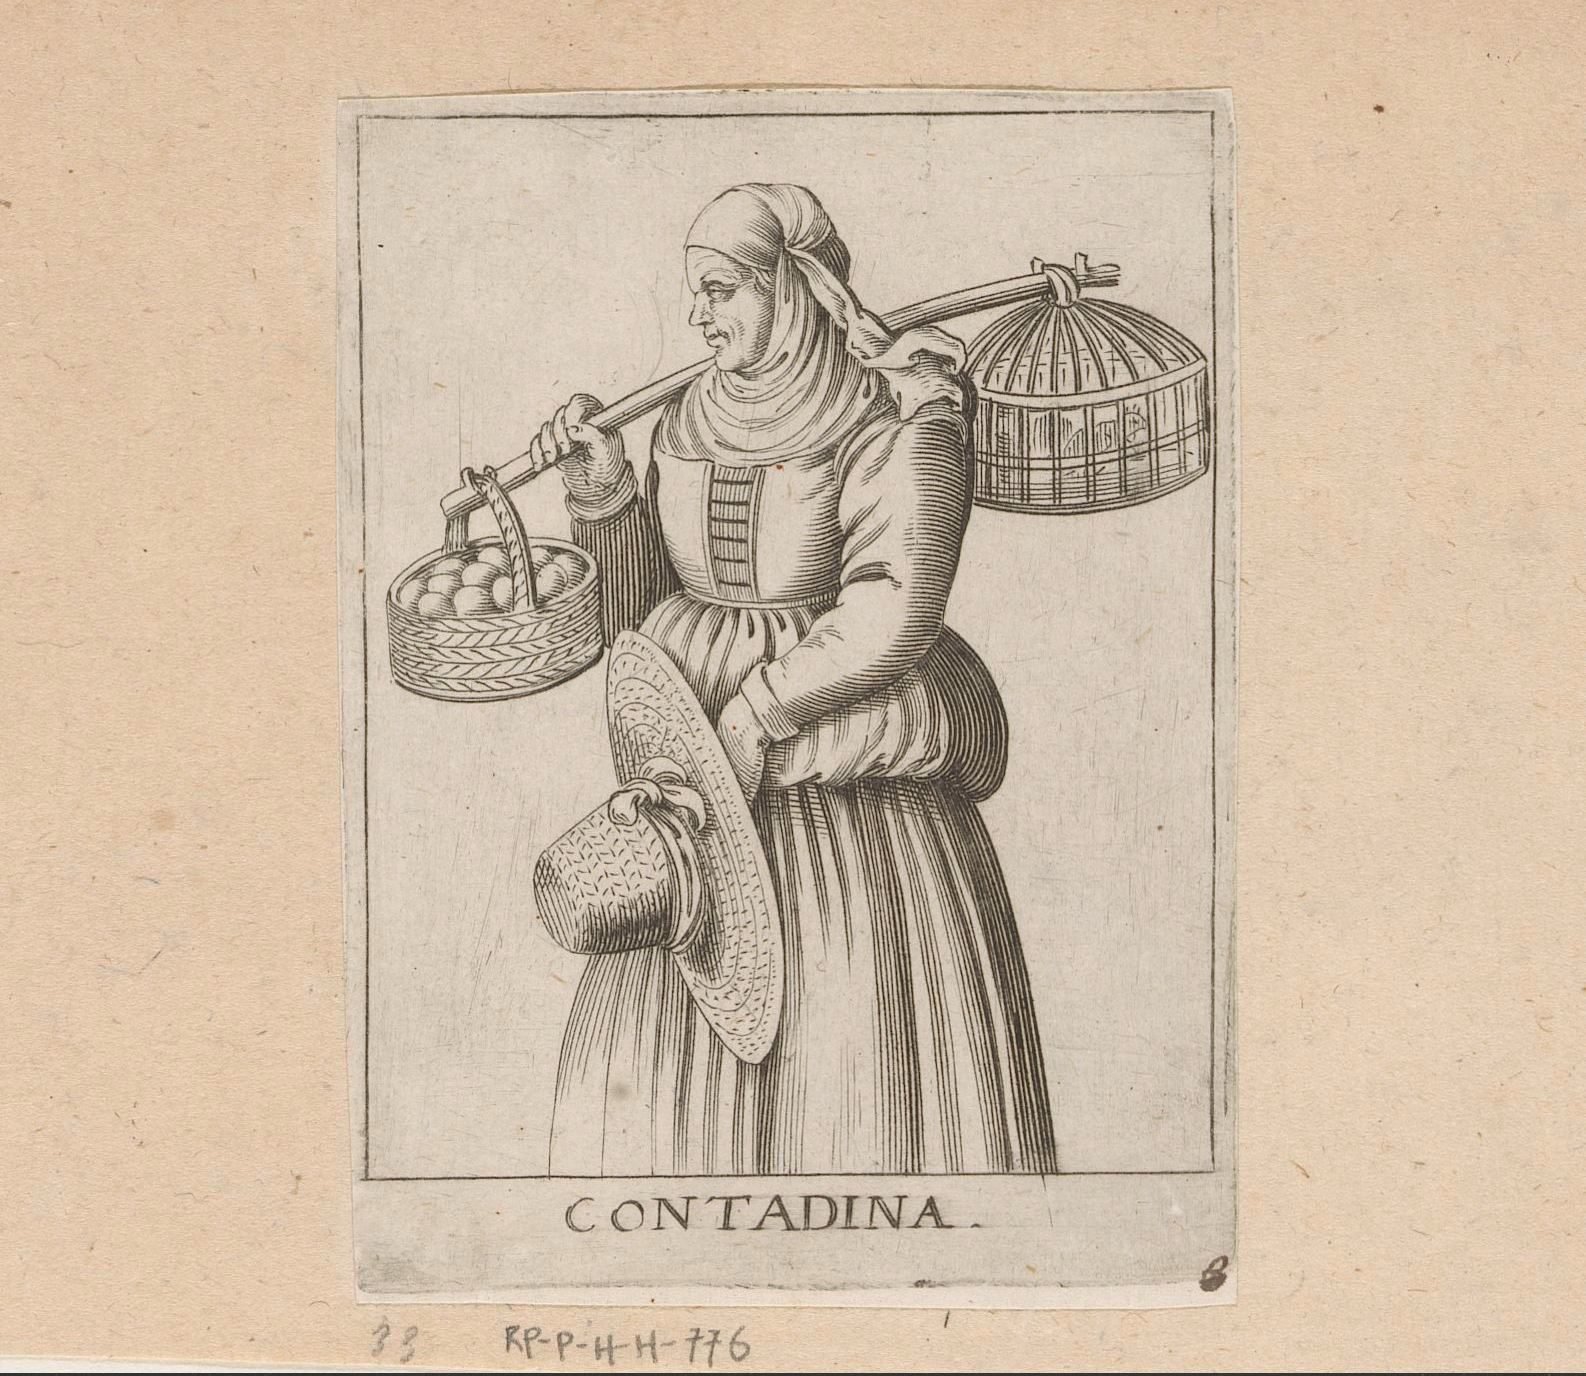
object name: print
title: Contadina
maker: francesco villamena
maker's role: draughtsman, painter, print maker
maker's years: 1566-1624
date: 1576-1624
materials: paper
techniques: engraving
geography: italy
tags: farmers, container made of plant material other than wood: basket, folk costume, regional costume, eggs, egg-dishes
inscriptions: number: ‘8’, collector's mark: Lugt 10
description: Staande boerin met in de hand een hoed en op de schouder een juk. Aan de juk hangen een mand met eieren en een kooi met daarin een dier. Titel in ondermarge.